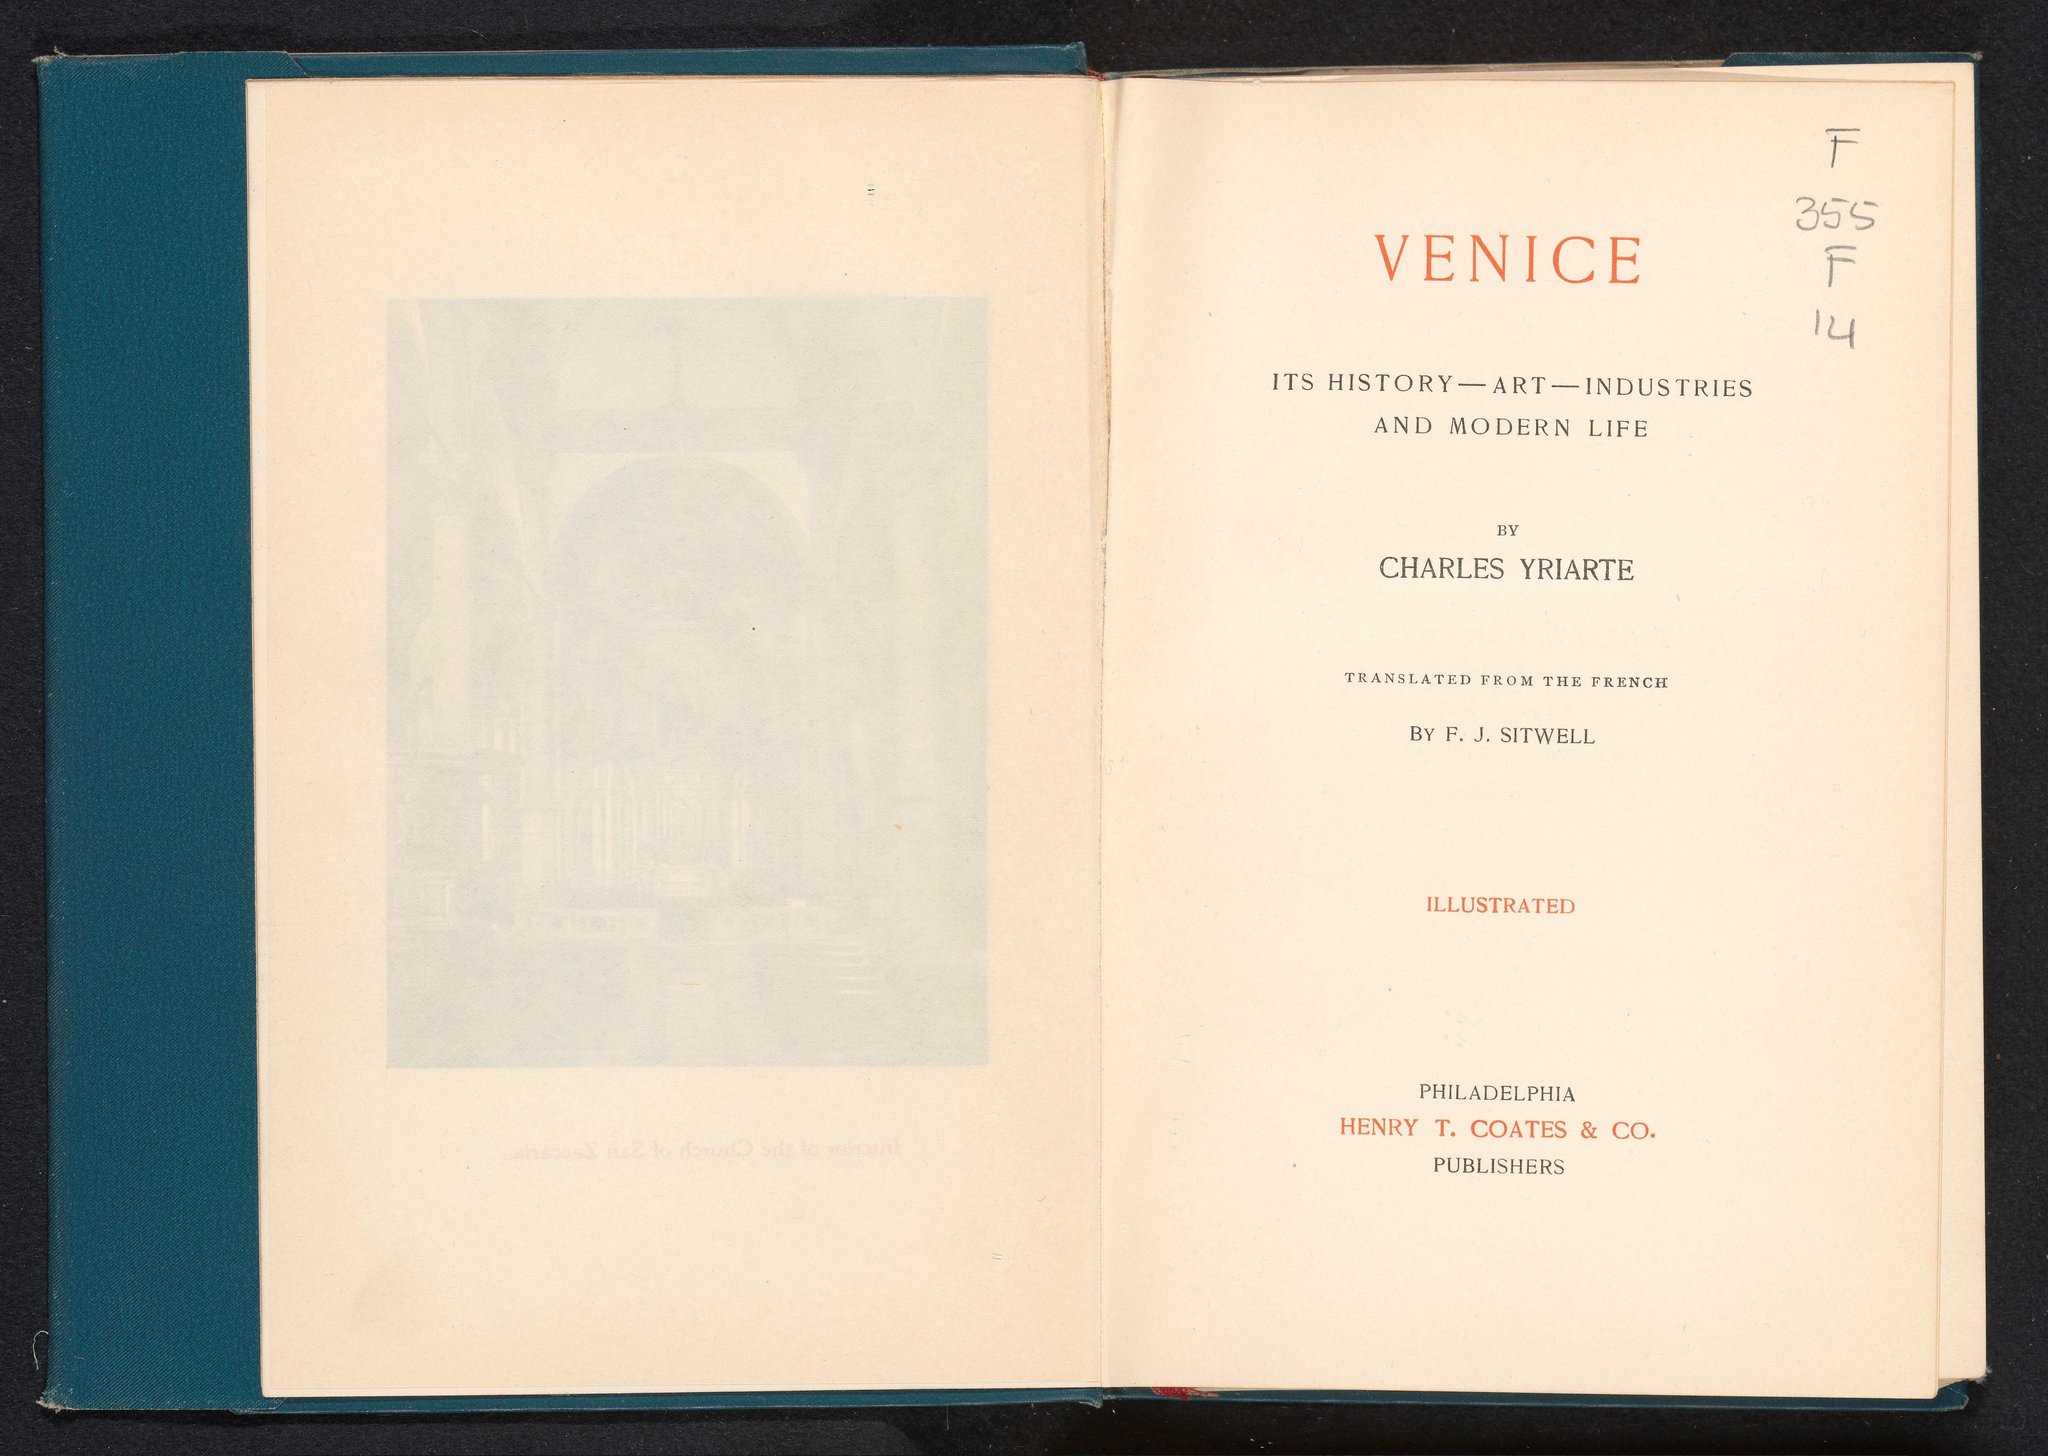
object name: book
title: Venice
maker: charles yriarte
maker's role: schrijver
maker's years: 1833-1898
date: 1892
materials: cardboard, linen, paper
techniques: lithograph, photoaquatint, printing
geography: philadelphia